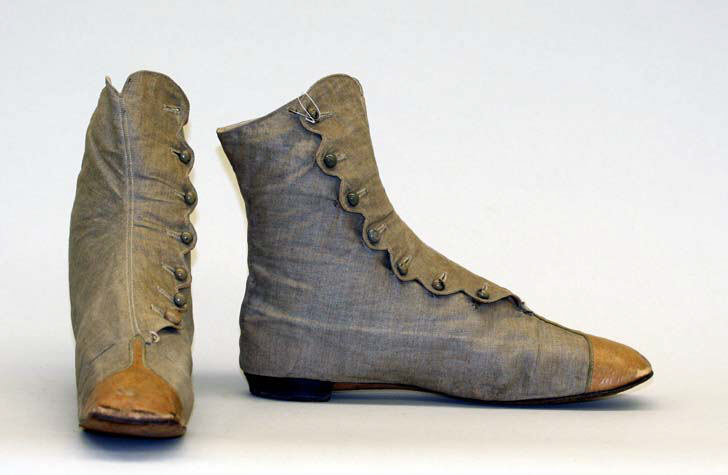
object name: shoe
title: Shoes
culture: american or european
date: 1860-1869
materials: linen